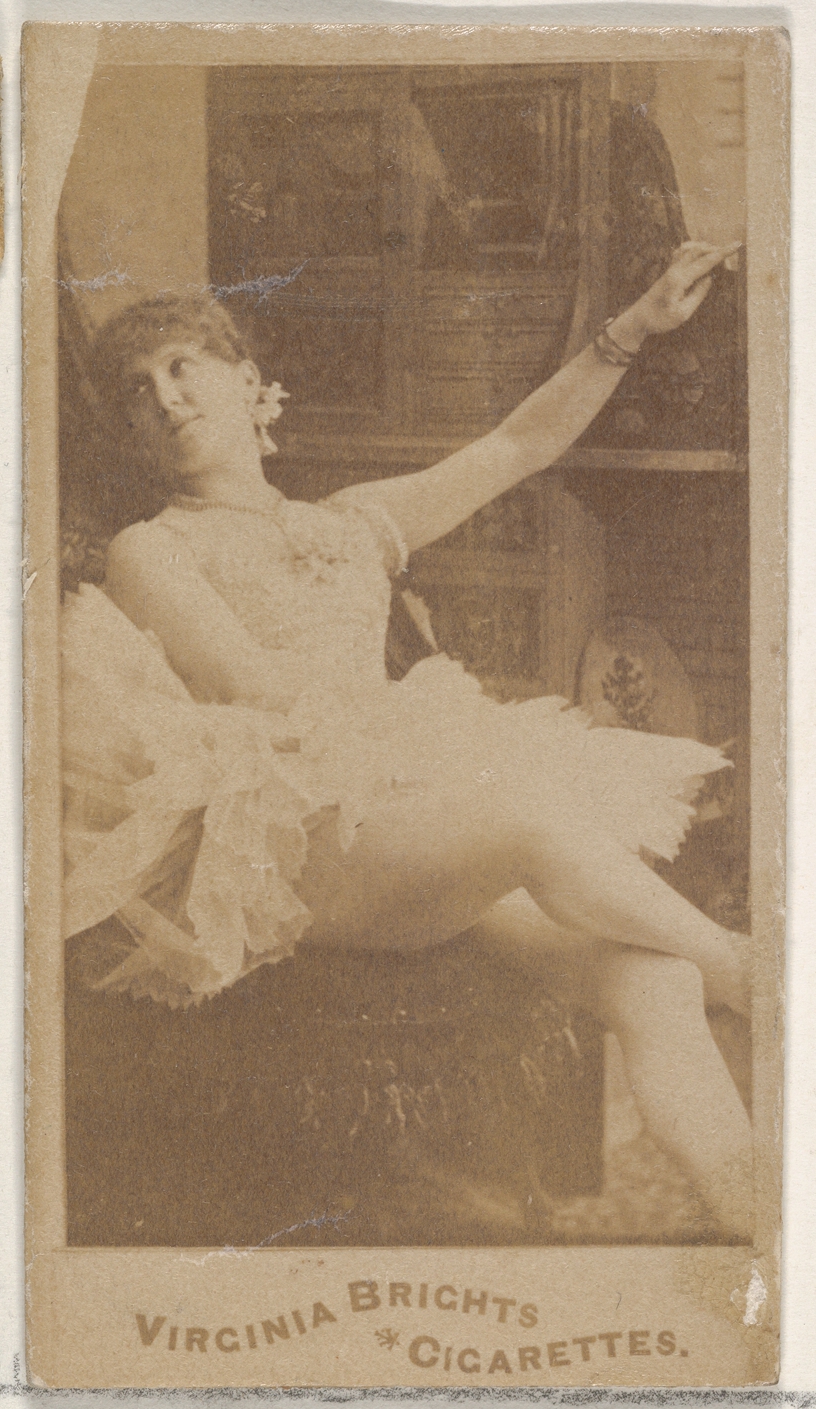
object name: photograph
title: From the Actors and Actresses series (N45, Type 4) for Virginia Brights Cigarettes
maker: allen & ginter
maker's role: publisher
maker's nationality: american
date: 1888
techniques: albumen silver print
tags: portraits,women,actresses